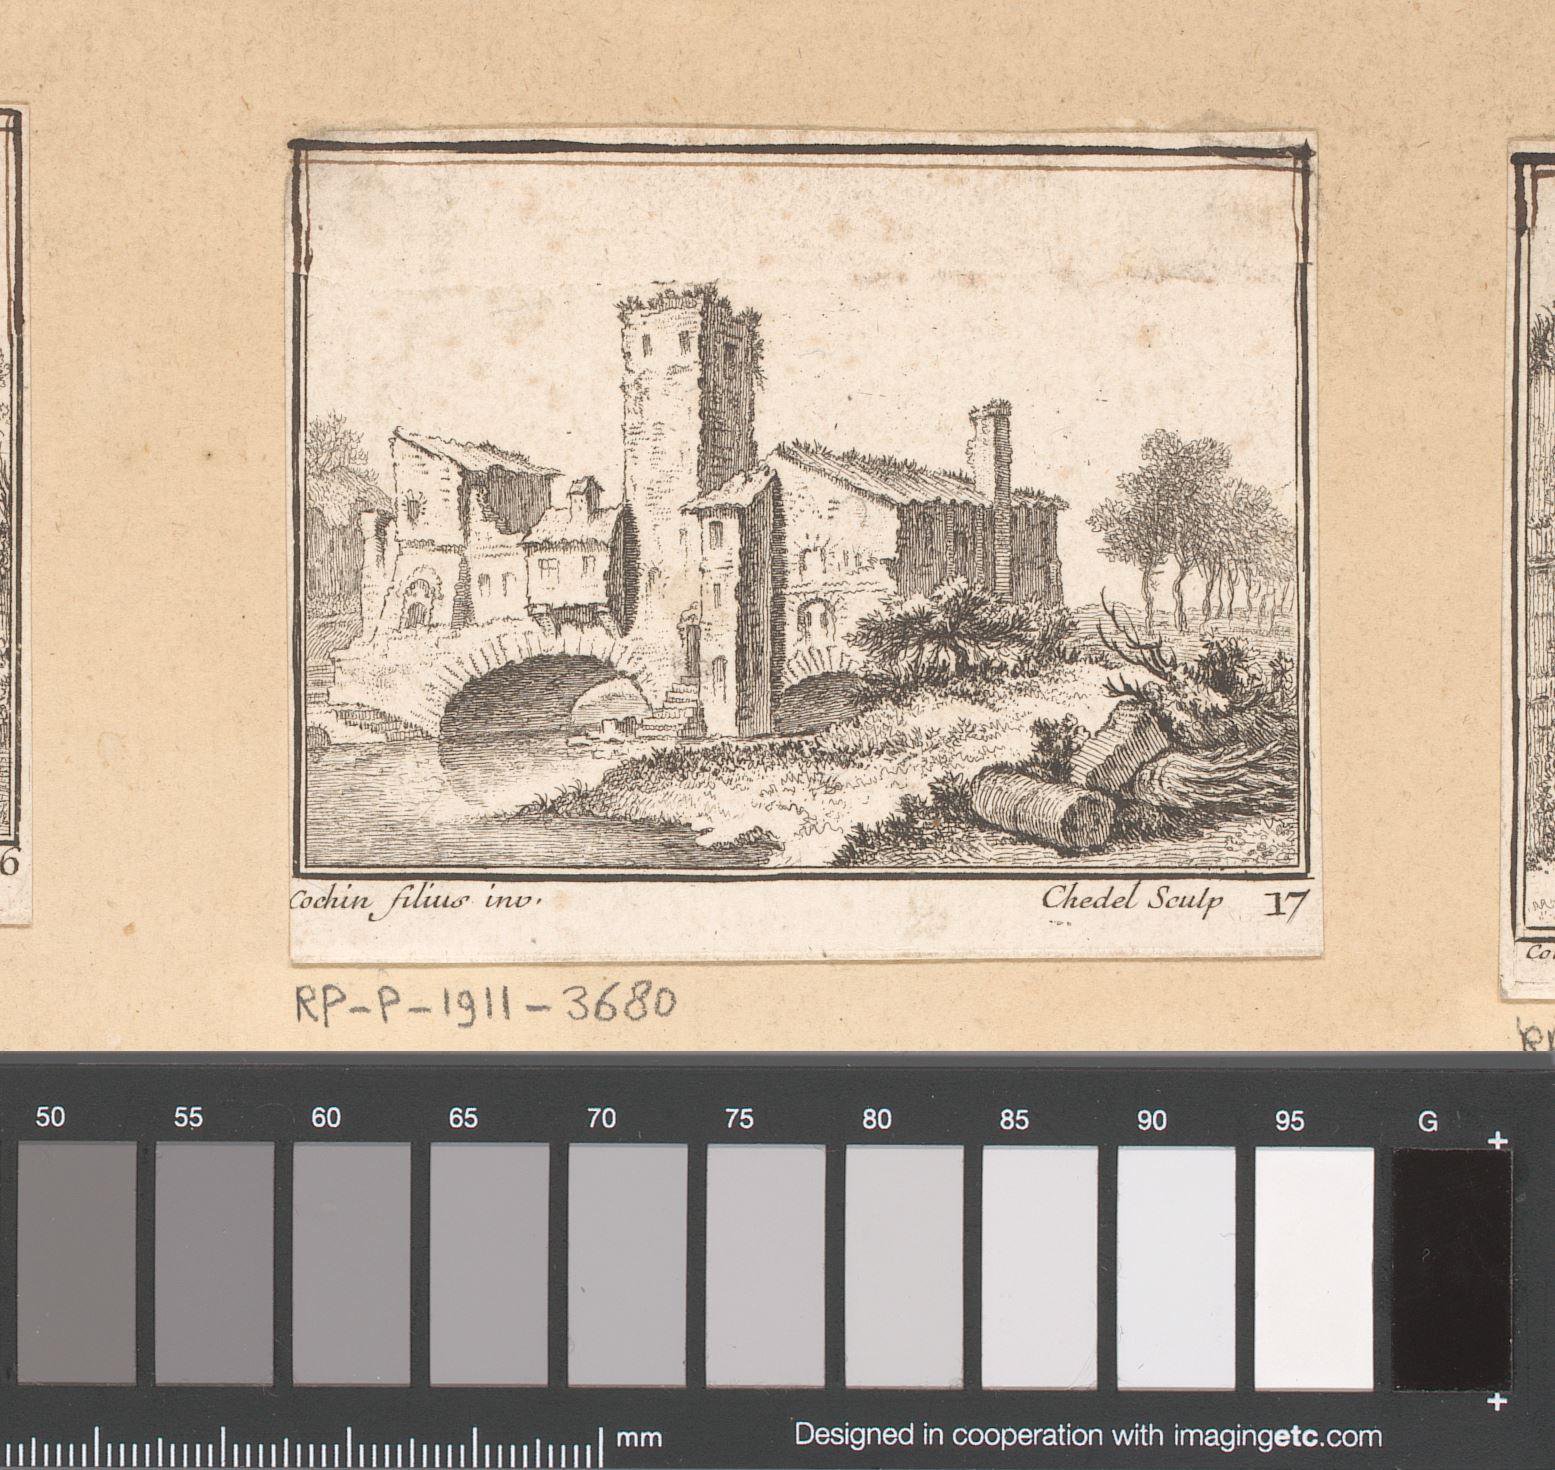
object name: print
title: Landschap met een gebouw met toren op een brug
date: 1725-1763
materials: ink, paper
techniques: etching, pen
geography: france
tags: city-view, and landscape with man-made constructions, landscape with bridge, viaduct or aqueduct, tower (of house or building)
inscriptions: collector's mark: Lugt 2228